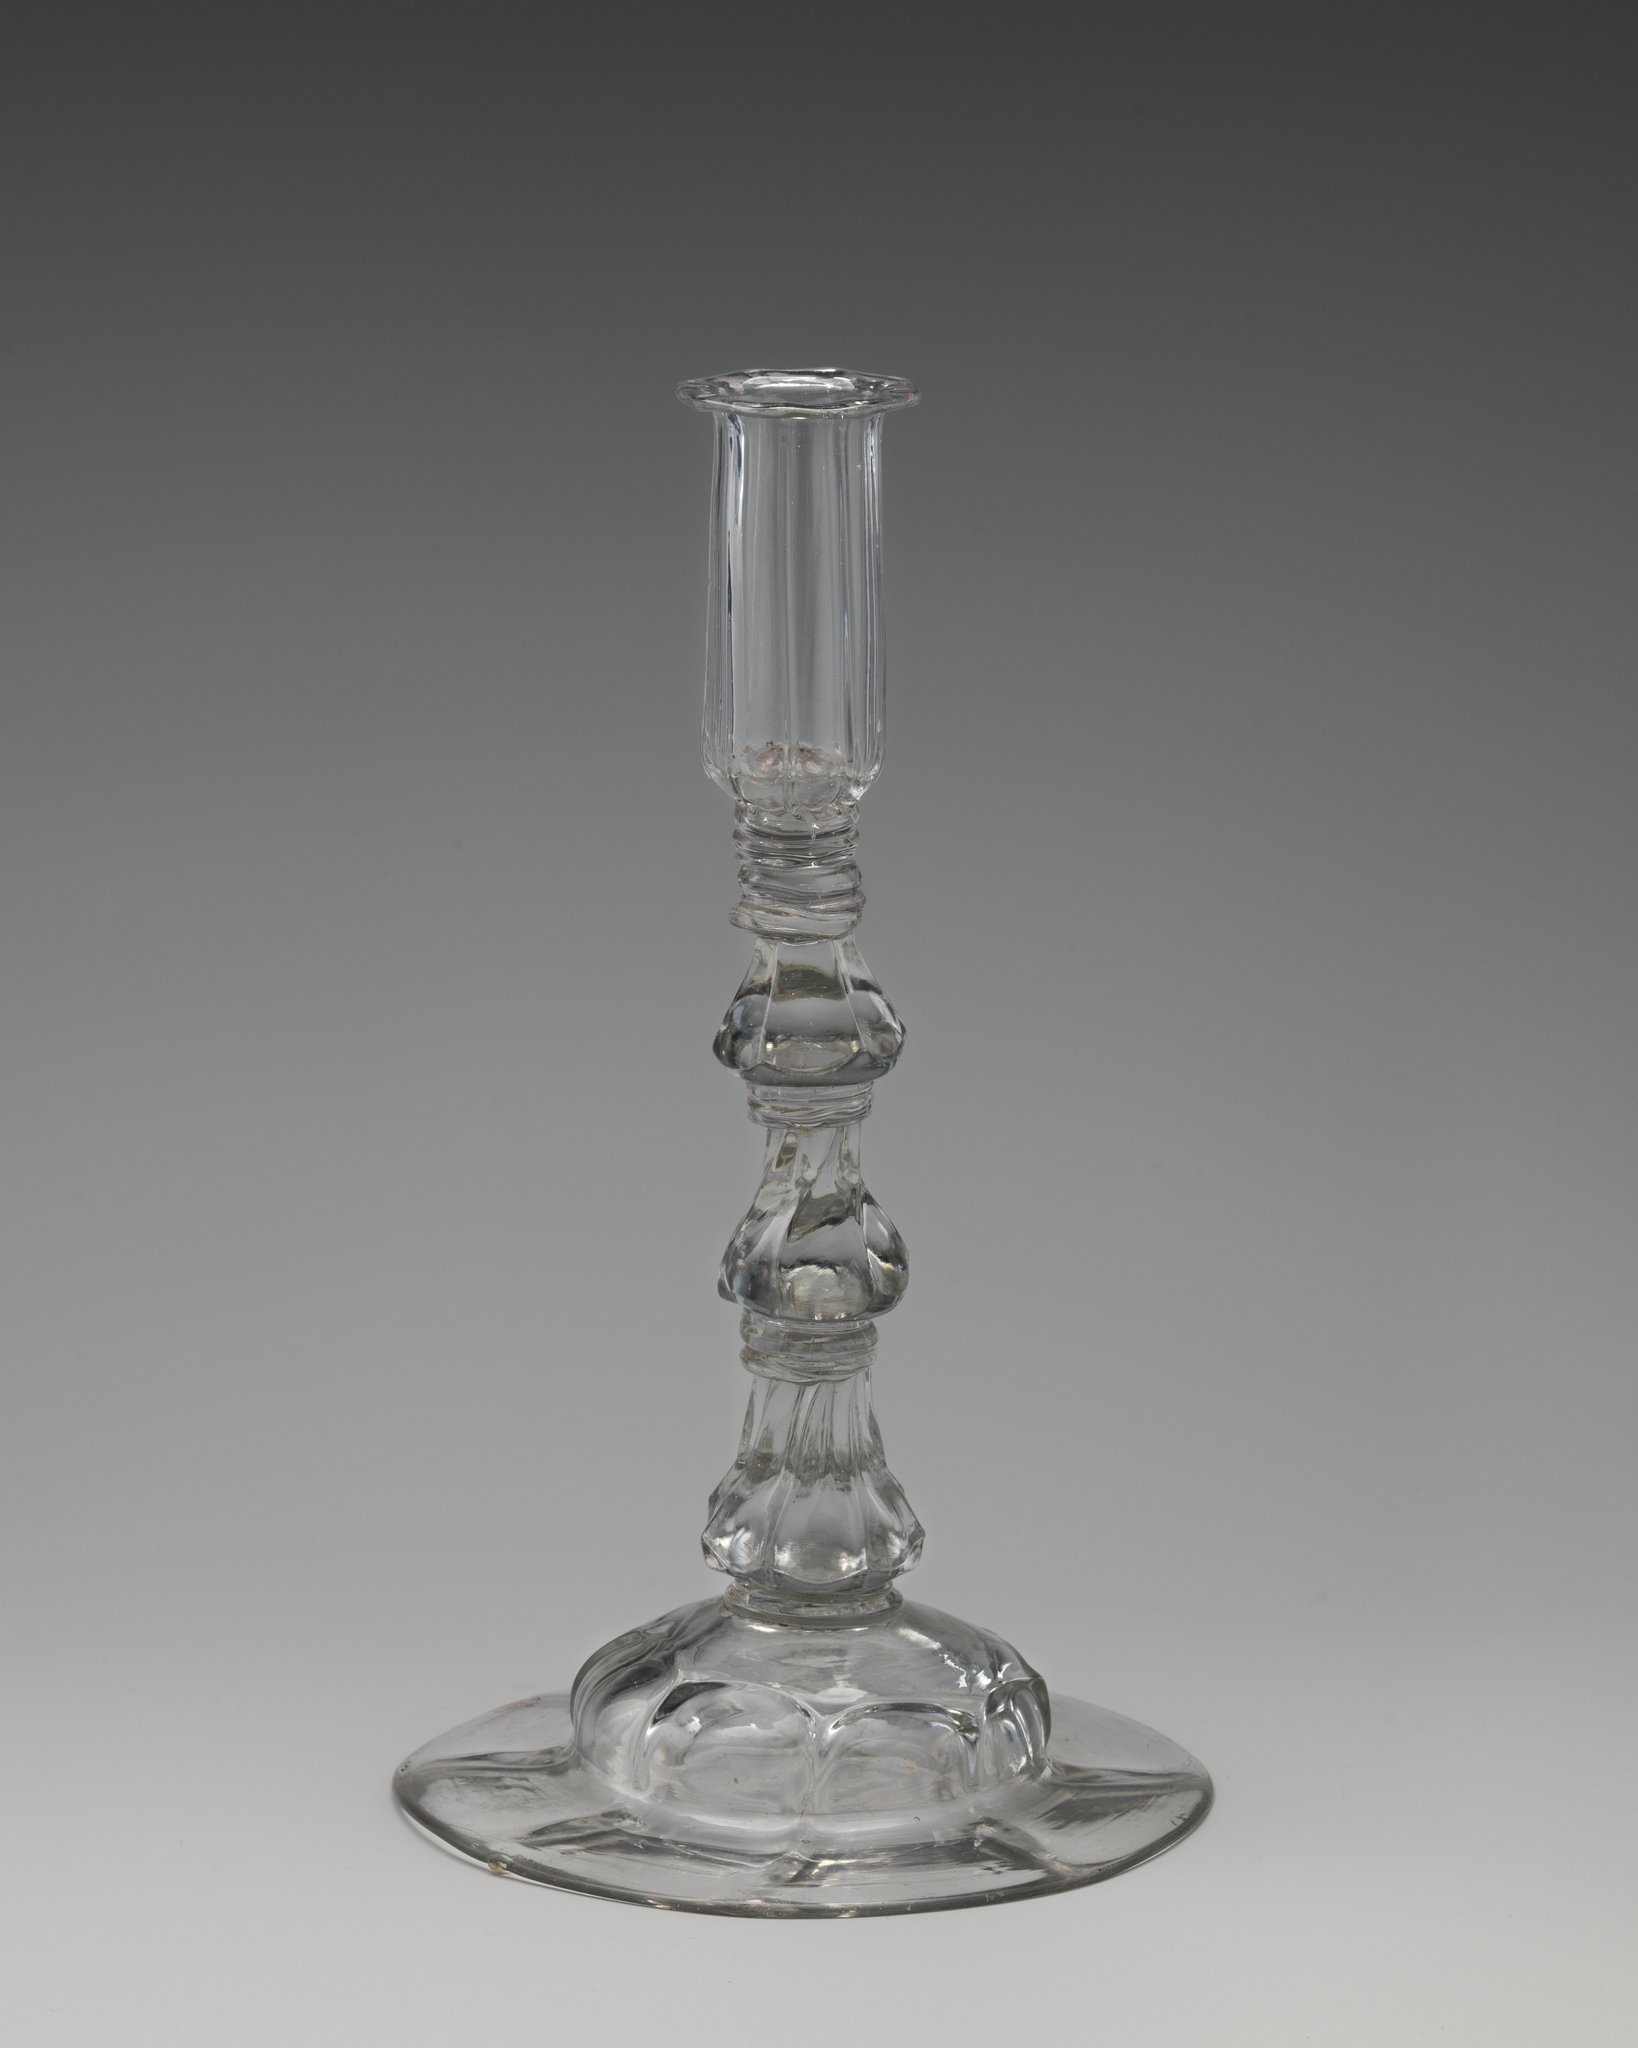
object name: candlestick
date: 1700-1725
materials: glass